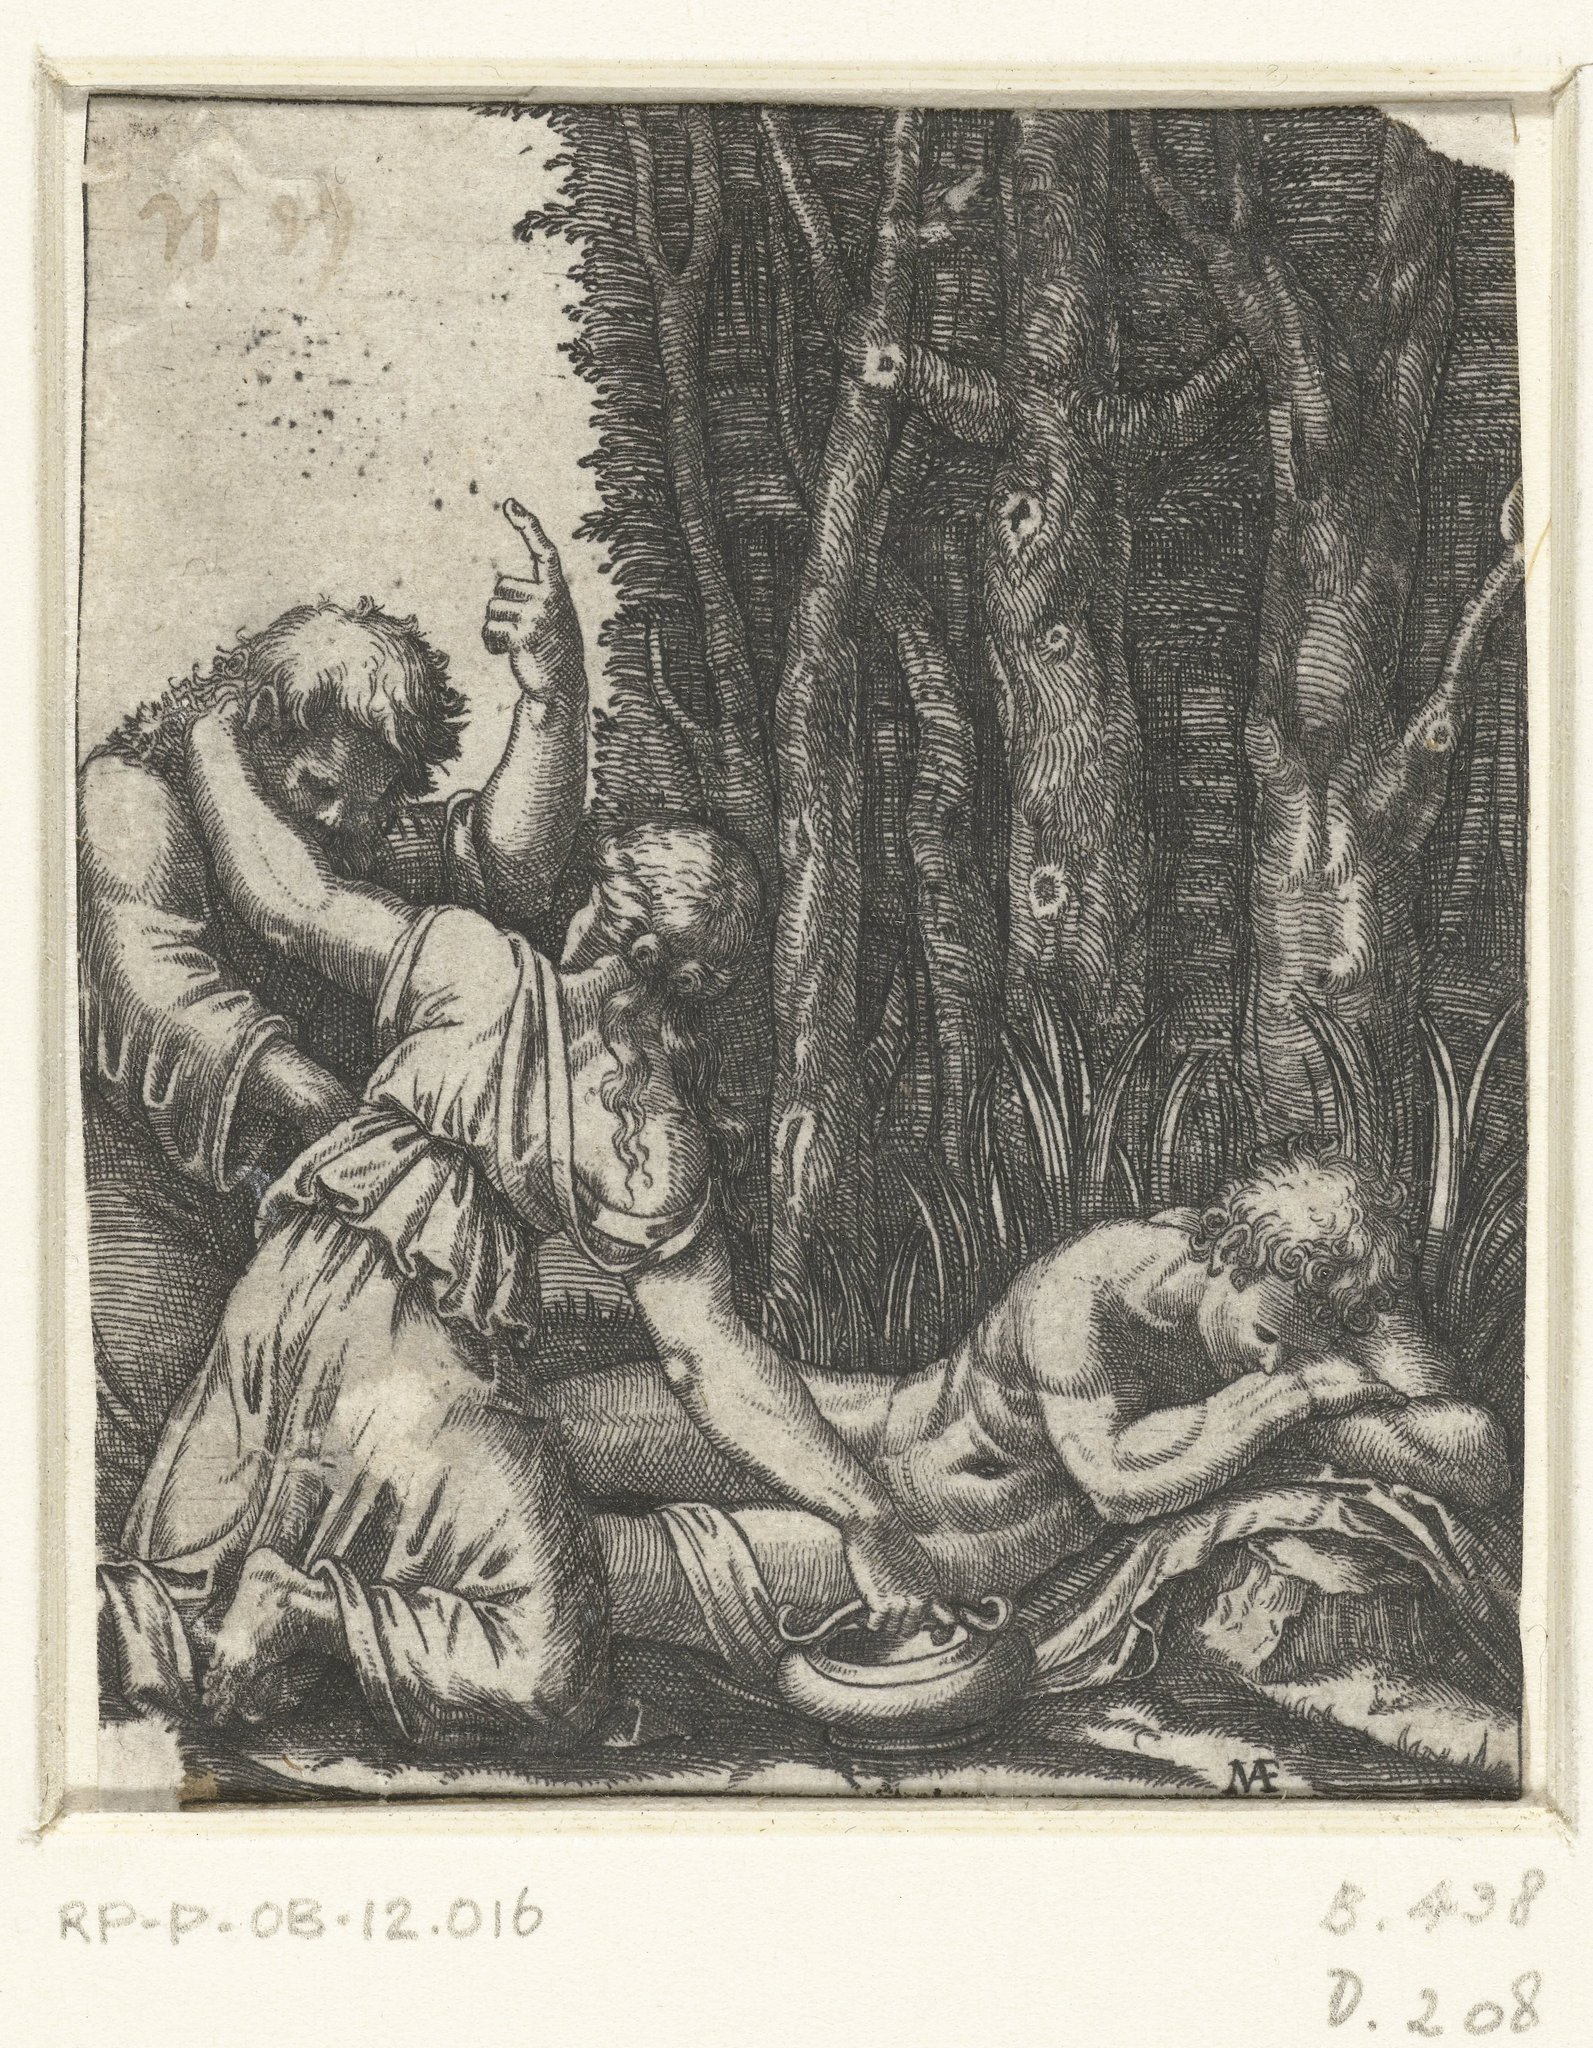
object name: print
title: Man en jonge vrouw bij slapende naakte man voor bosrand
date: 1510-1527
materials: paper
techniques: engraving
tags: sleeping; unconsciousness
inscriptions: collector's mark: Lugt 2228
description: Prent mogelijk naar ontwerp van Francesco di Francia.